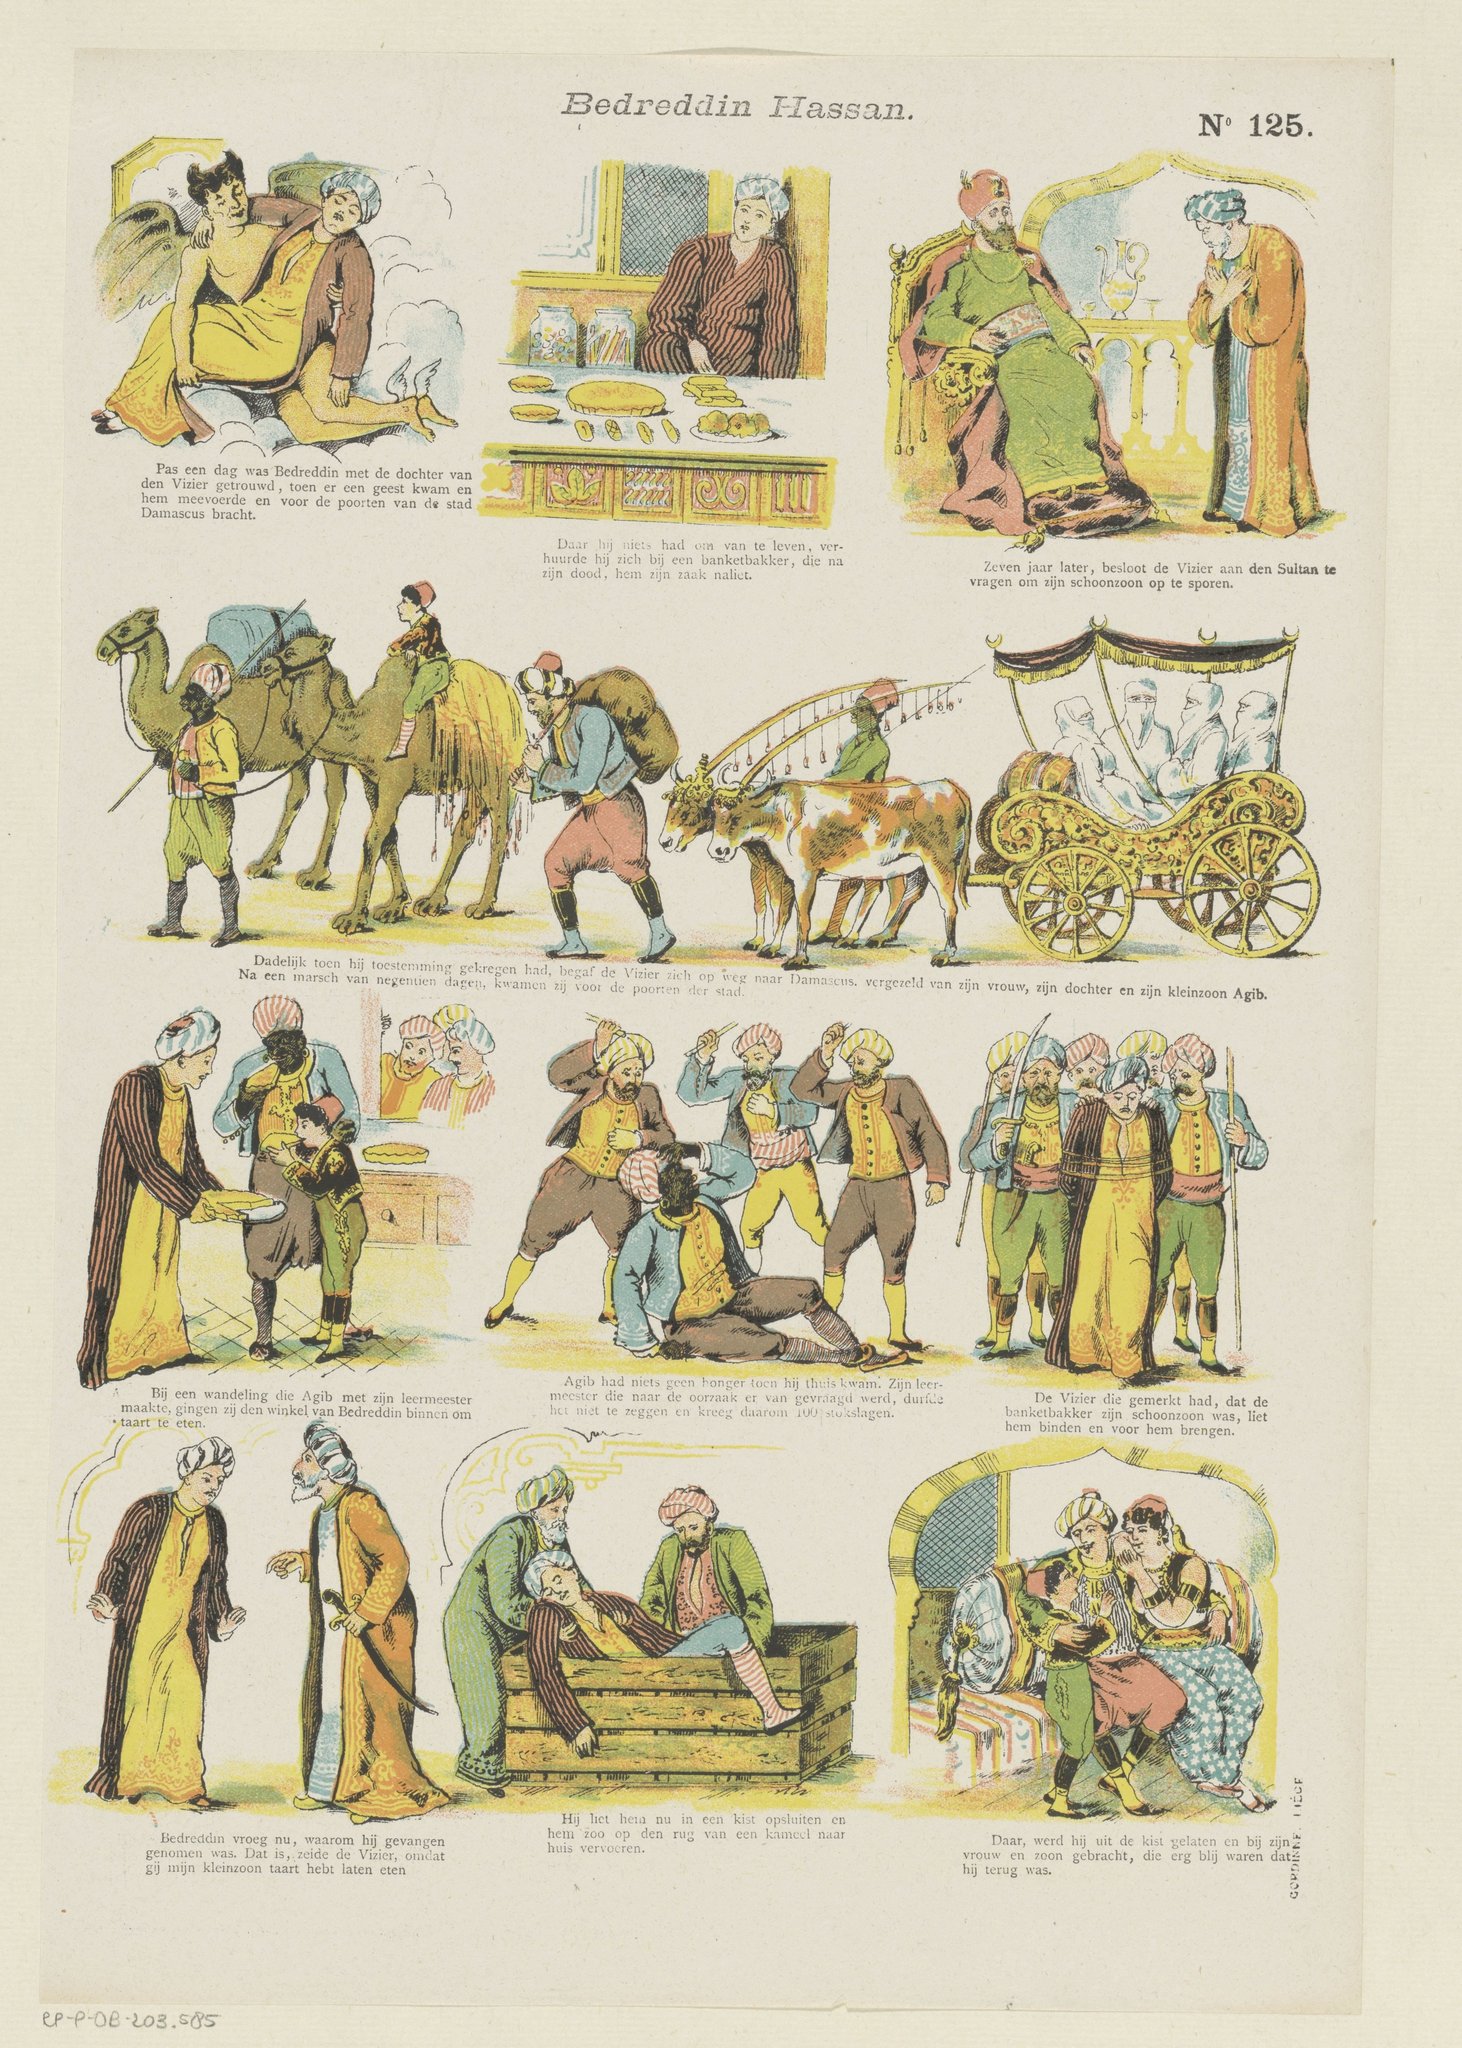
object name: popular print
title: Bedreddin Hassan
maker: Anonymous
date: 1894-1959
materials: paper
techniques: lithograph, letterpress printing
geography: liège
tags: tales and fairy tales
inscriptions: collector's mark: Lugt 2760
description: Blad met 12 voorstellingen uit het verhaal van Bedreddin Hassan (verhaal uit Duizend-en-een-nacht). Onder elke afbeelding een onderschrift. Genummerd rechtsboven: No 125.